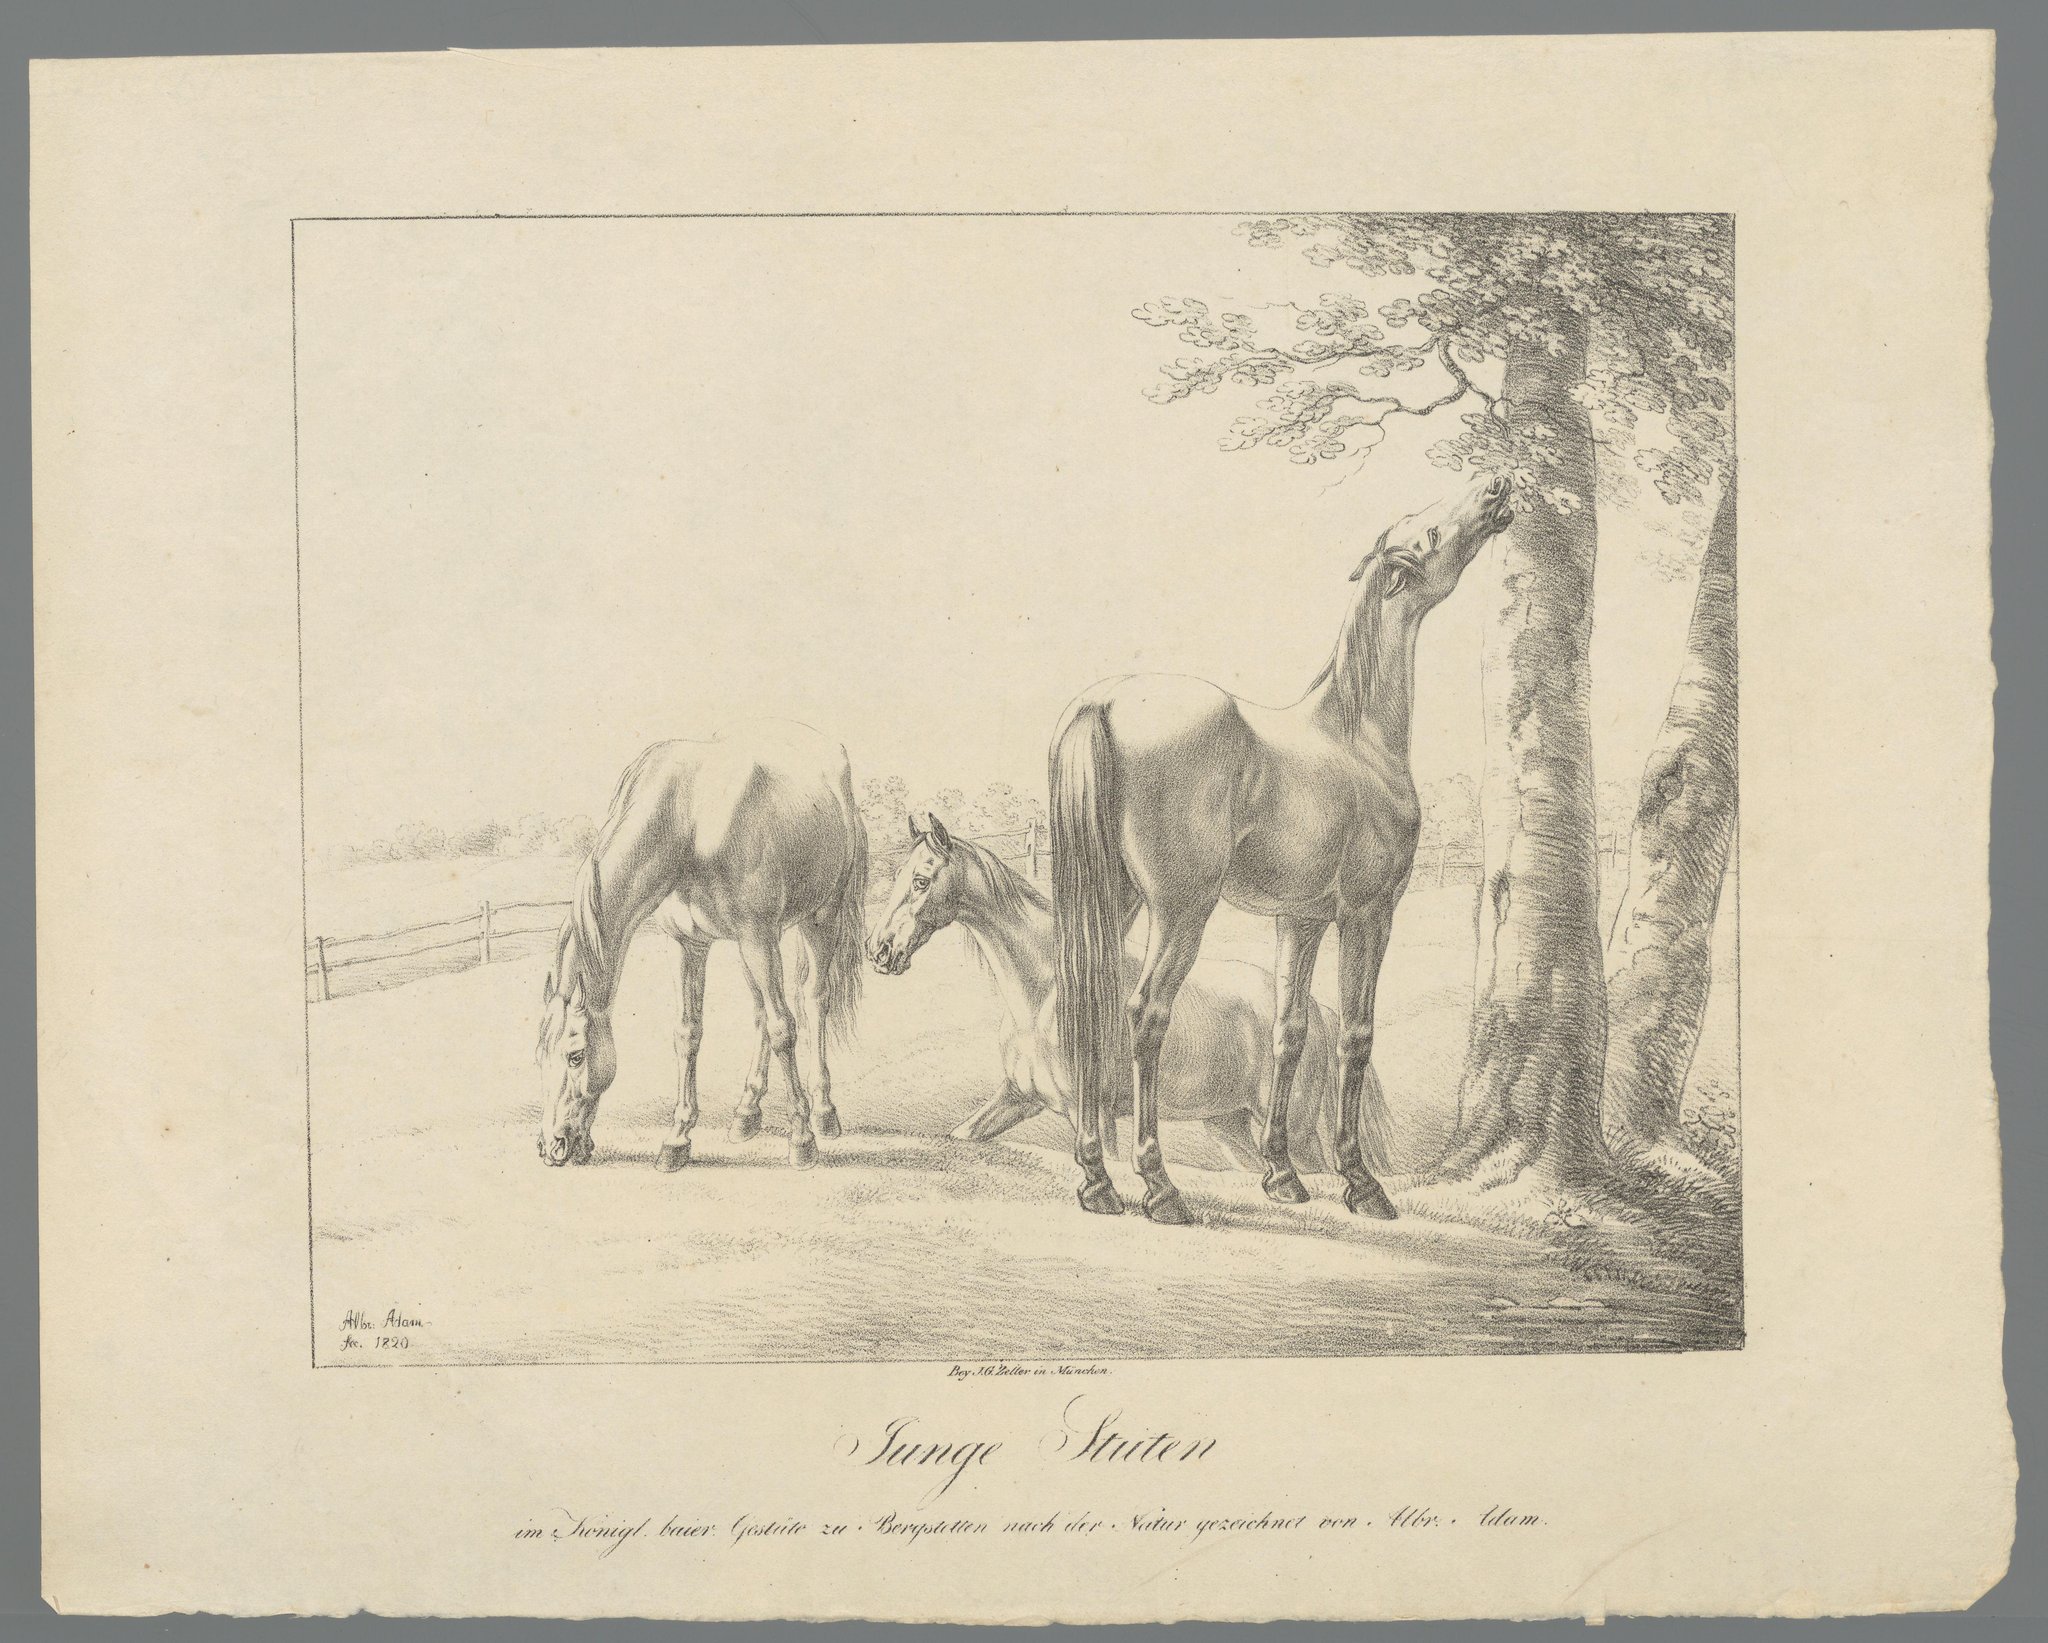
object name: print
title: Dierstudies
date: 1820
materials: paper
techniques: lithograph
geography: munich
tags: horse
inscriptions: collector's mark: Lugt 2228